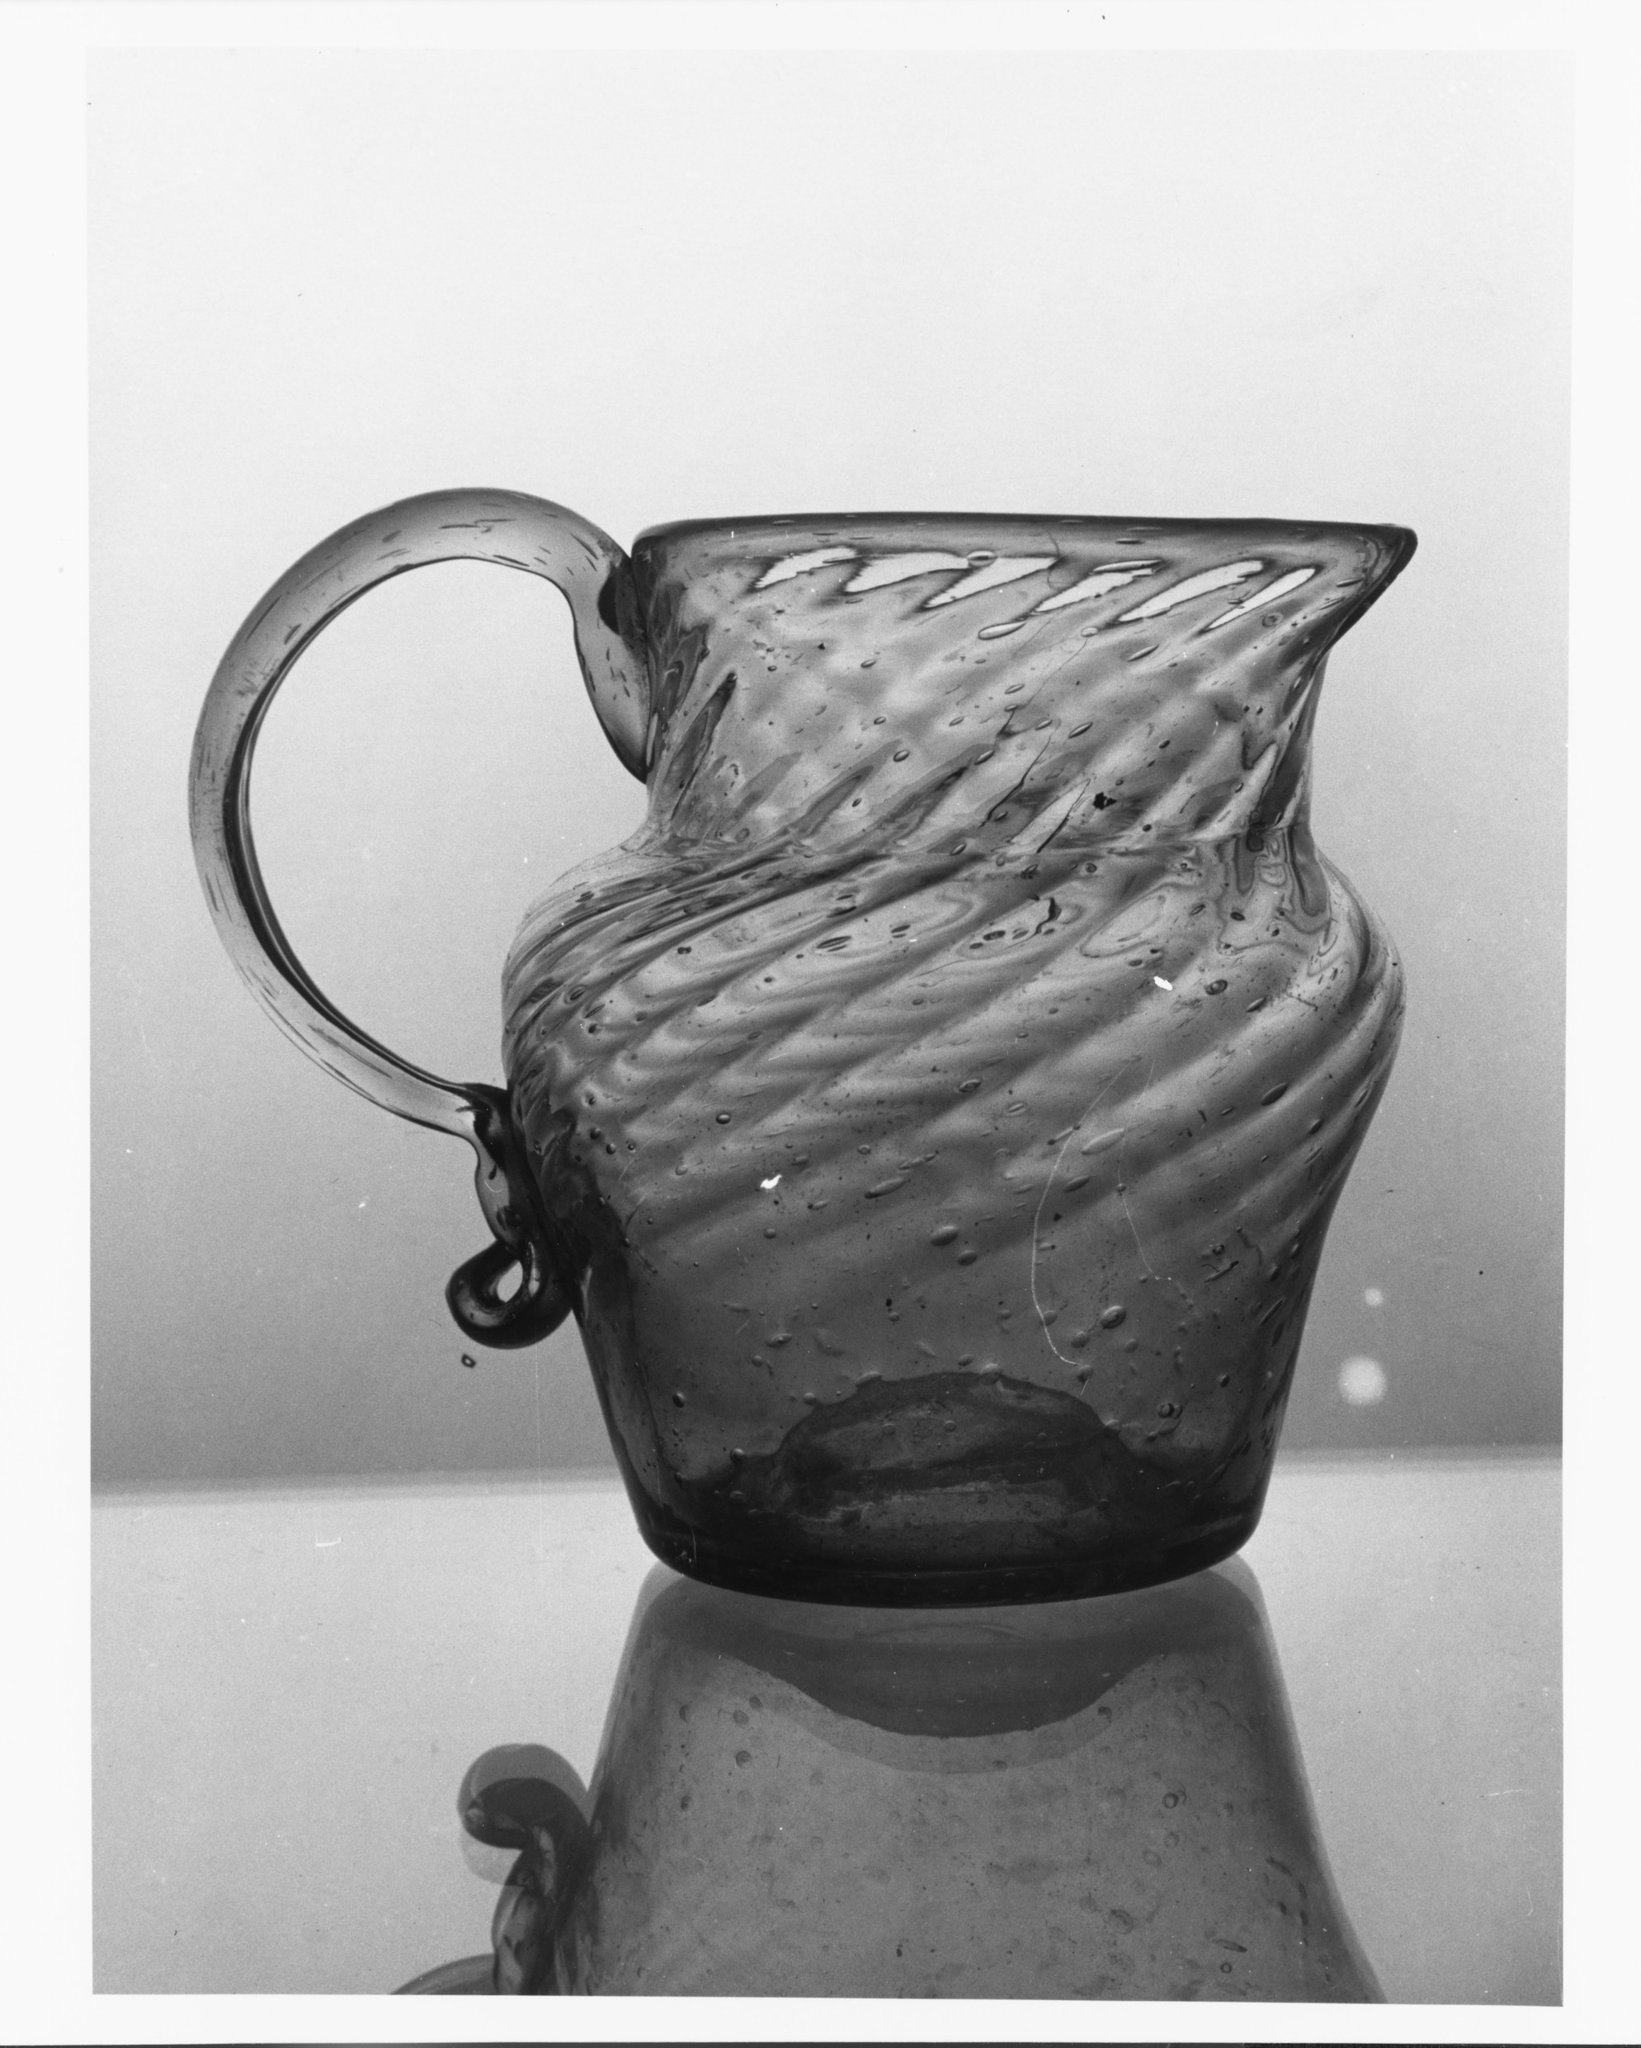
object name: pitcher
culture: american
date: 1800-1830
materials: gemstone, glass, lead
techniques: glassblowing, molding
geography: united states